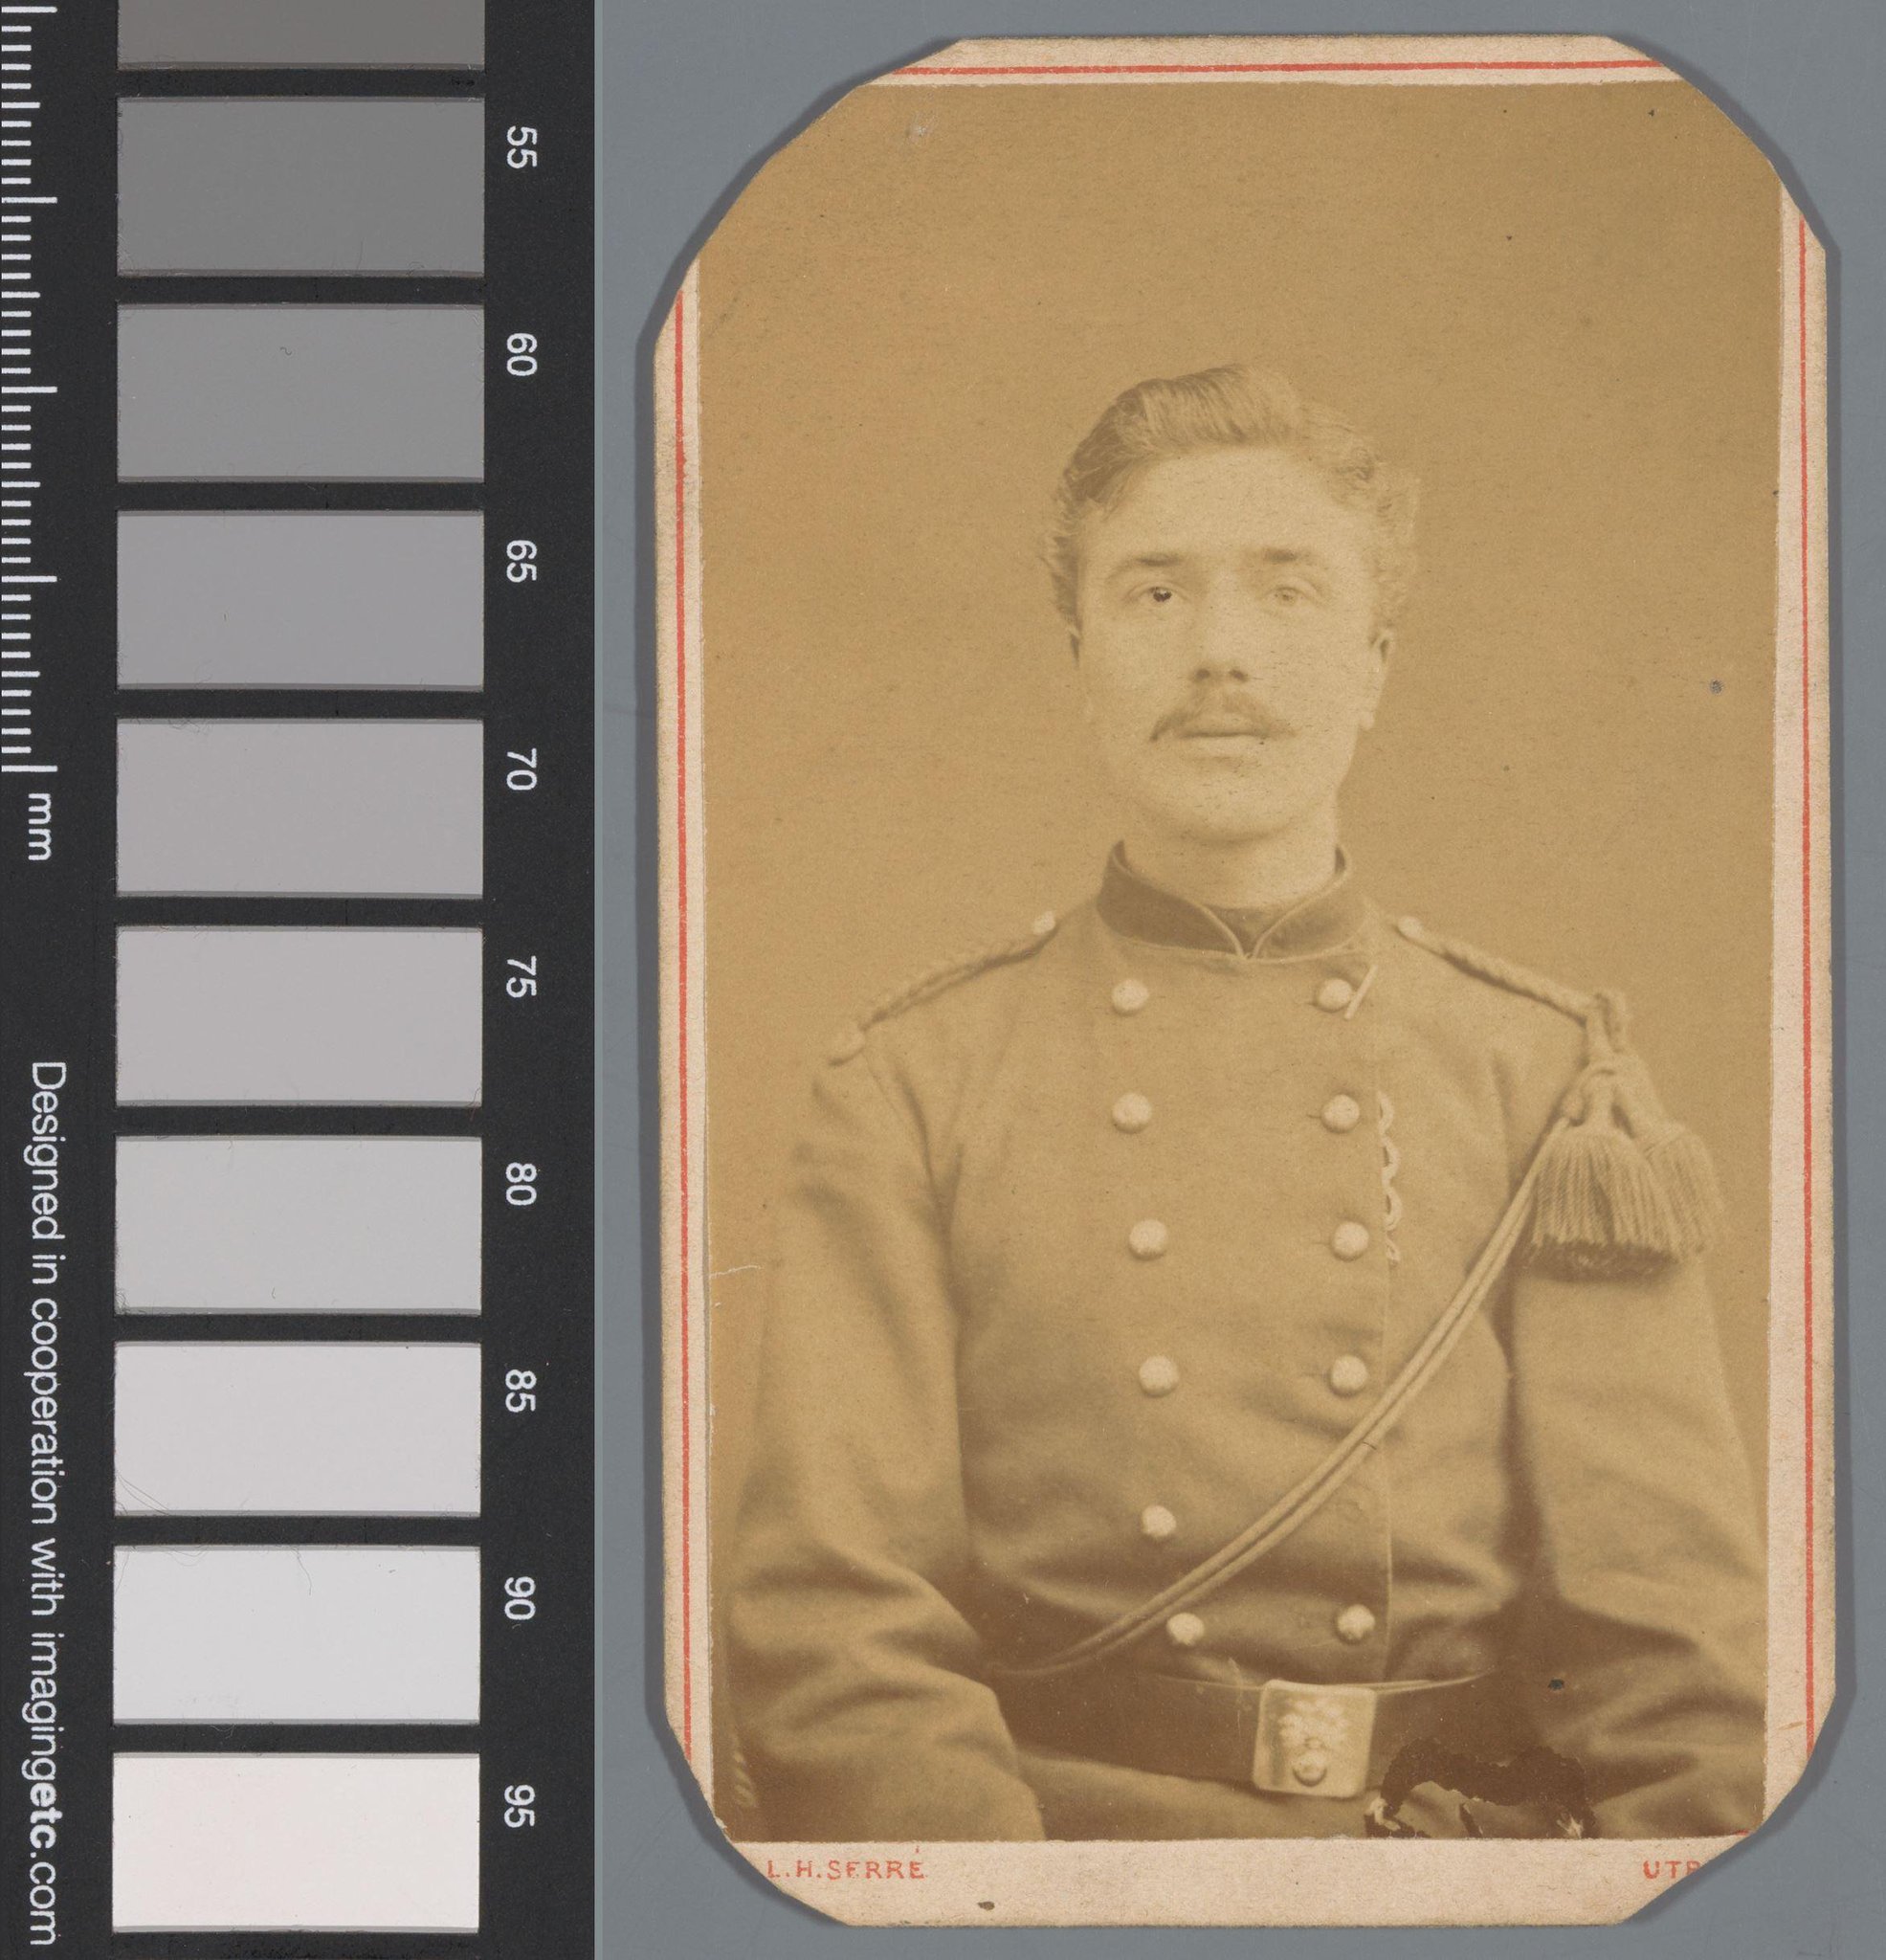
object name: photograph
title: Portret van een onbekende man in uniform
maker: lodewijk hendrikus serré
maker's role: fotograaf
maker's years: 1847-1897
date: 1877-1897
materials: cardboard, paper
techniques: albumen print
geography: utrecht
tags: adult man, anonymous historical person portrayed, (military) uniforms, utrecht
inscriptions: inscription: ‘L.H. Serré Utr[...]’, inscription: ‘Photographisch/ Atelier/ van/ L.H.Serré/ Utrecht/ Weerd Singel No. 392./ Gouda en Amersfoort./ Van ieder soort portret kunnen vergrootingen/ worden geleverd./ Deze photographie kan steeds nabesteld worden.’